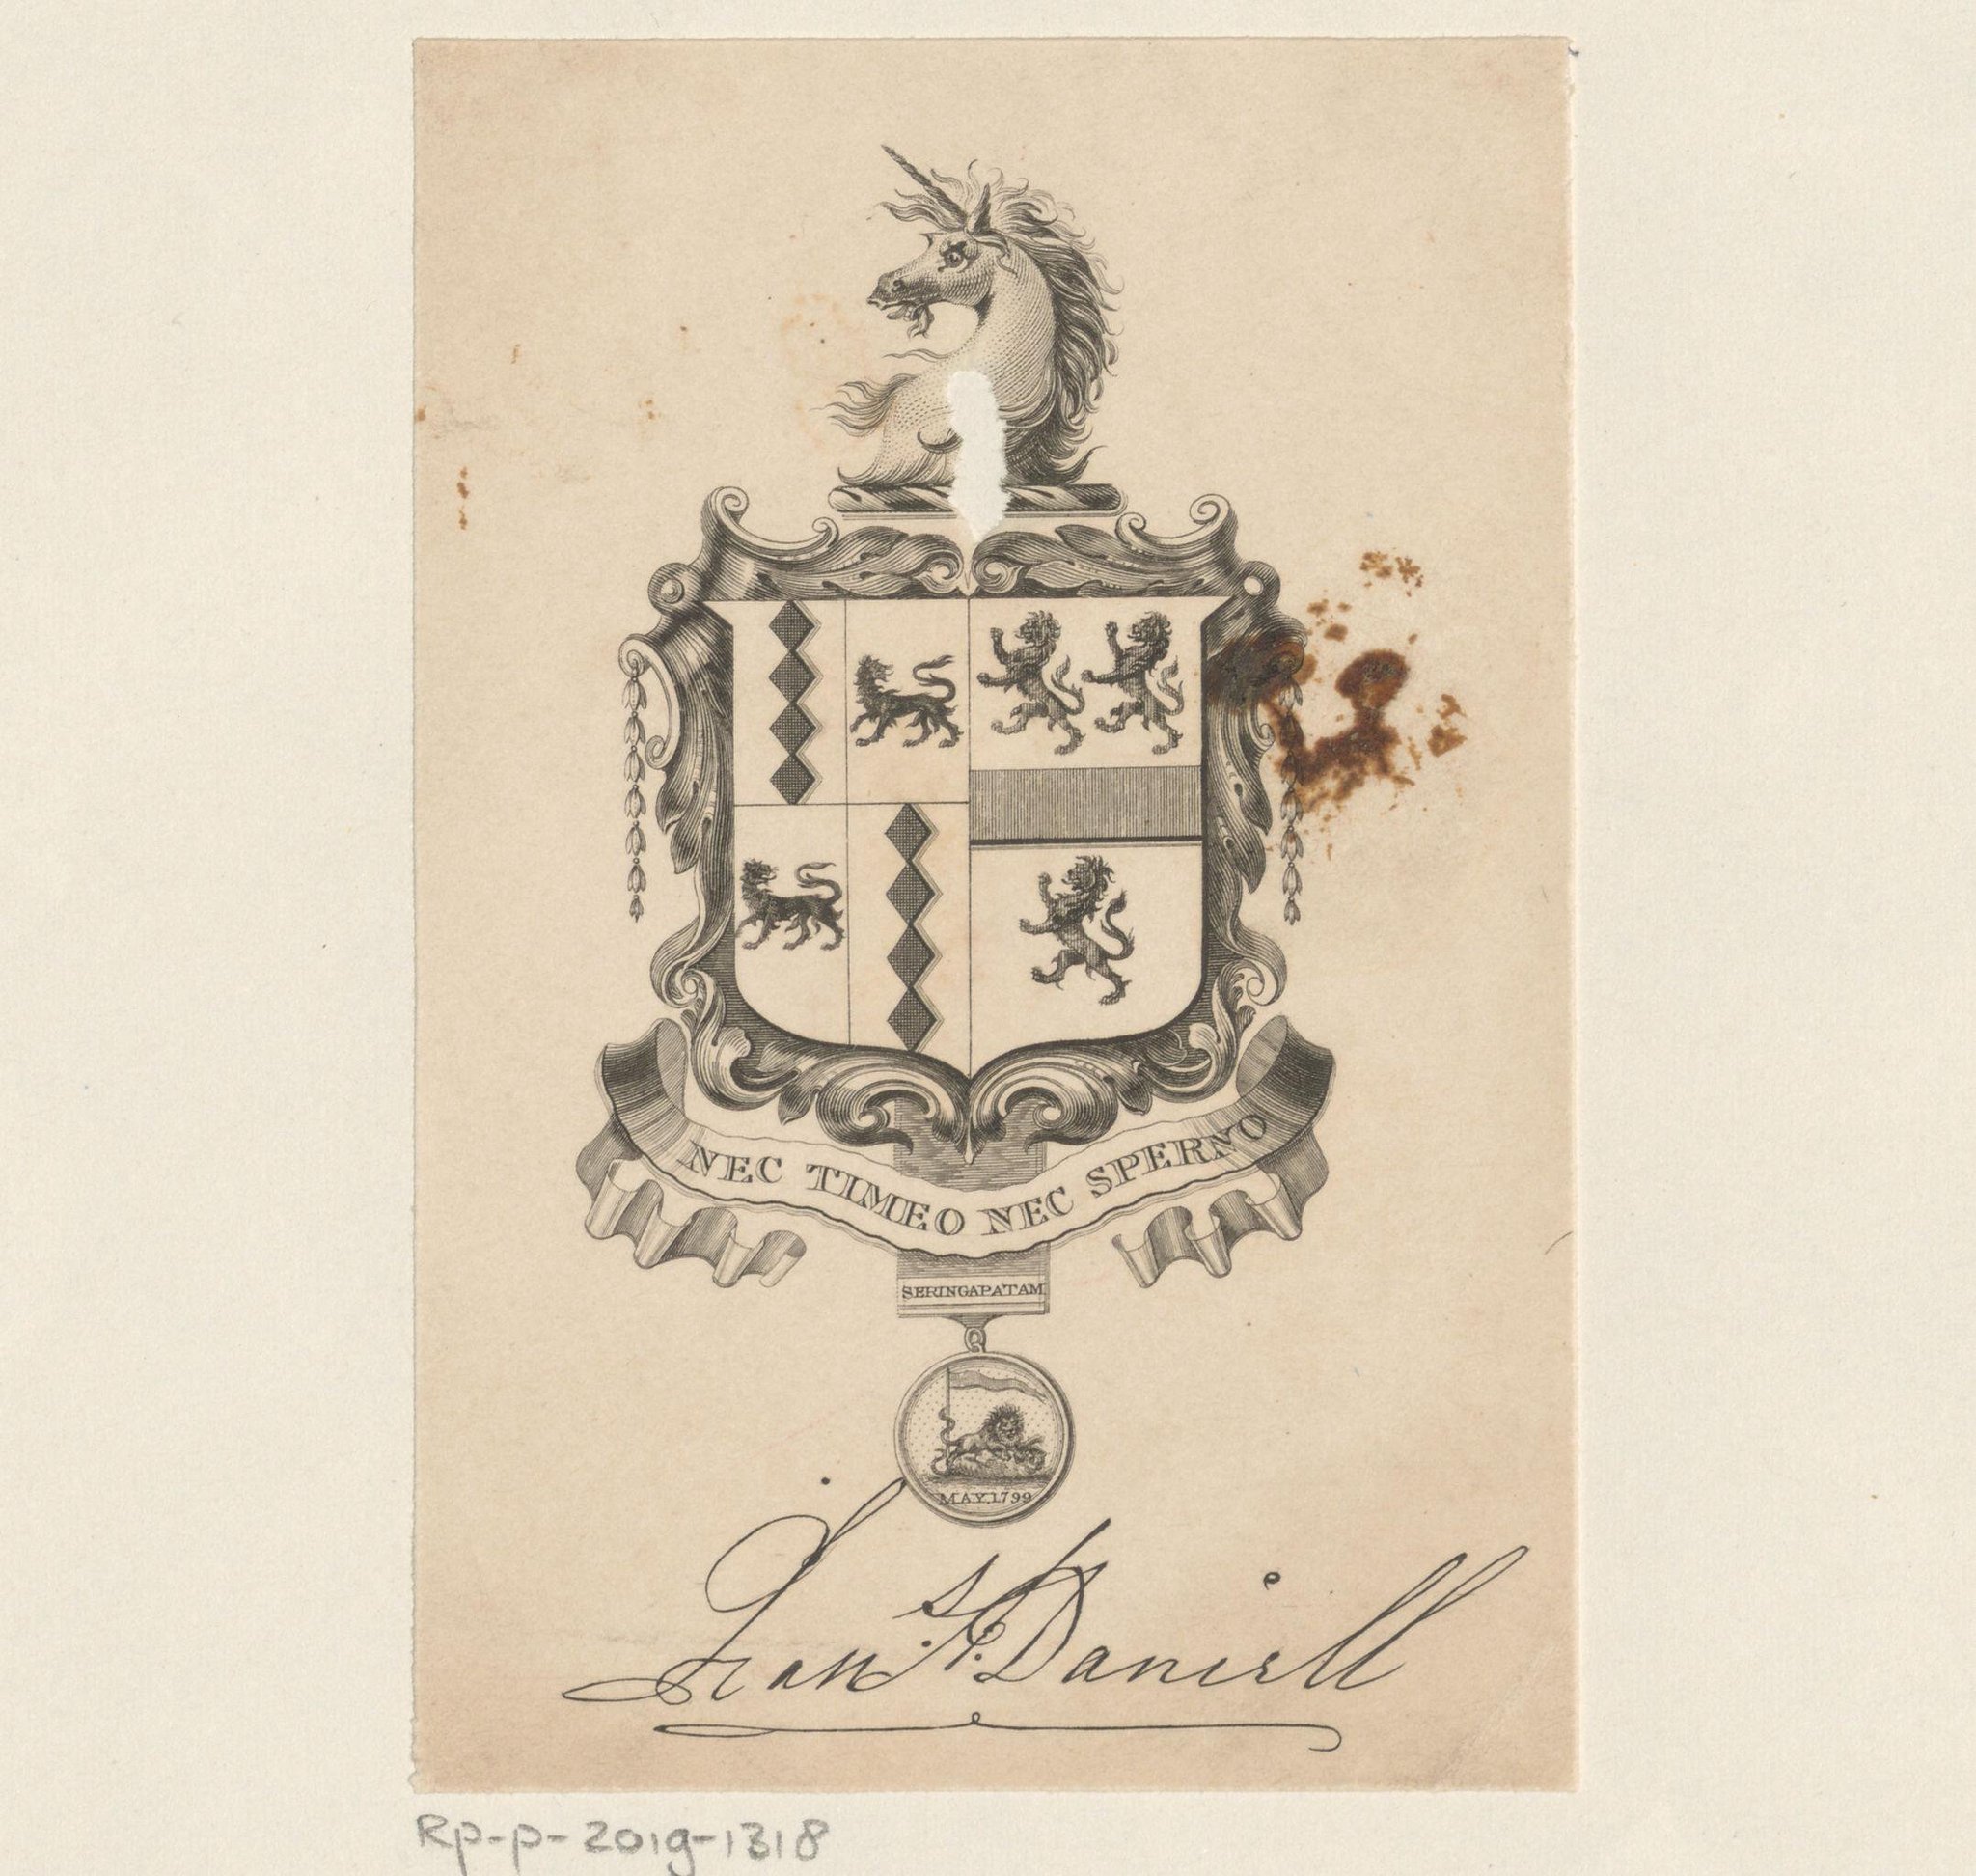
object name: bookplate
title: Ex libris van Francis Daniell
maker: Anonymous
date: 1799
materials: paper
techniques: engraving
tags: armorial bearing, heraldry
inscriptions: date